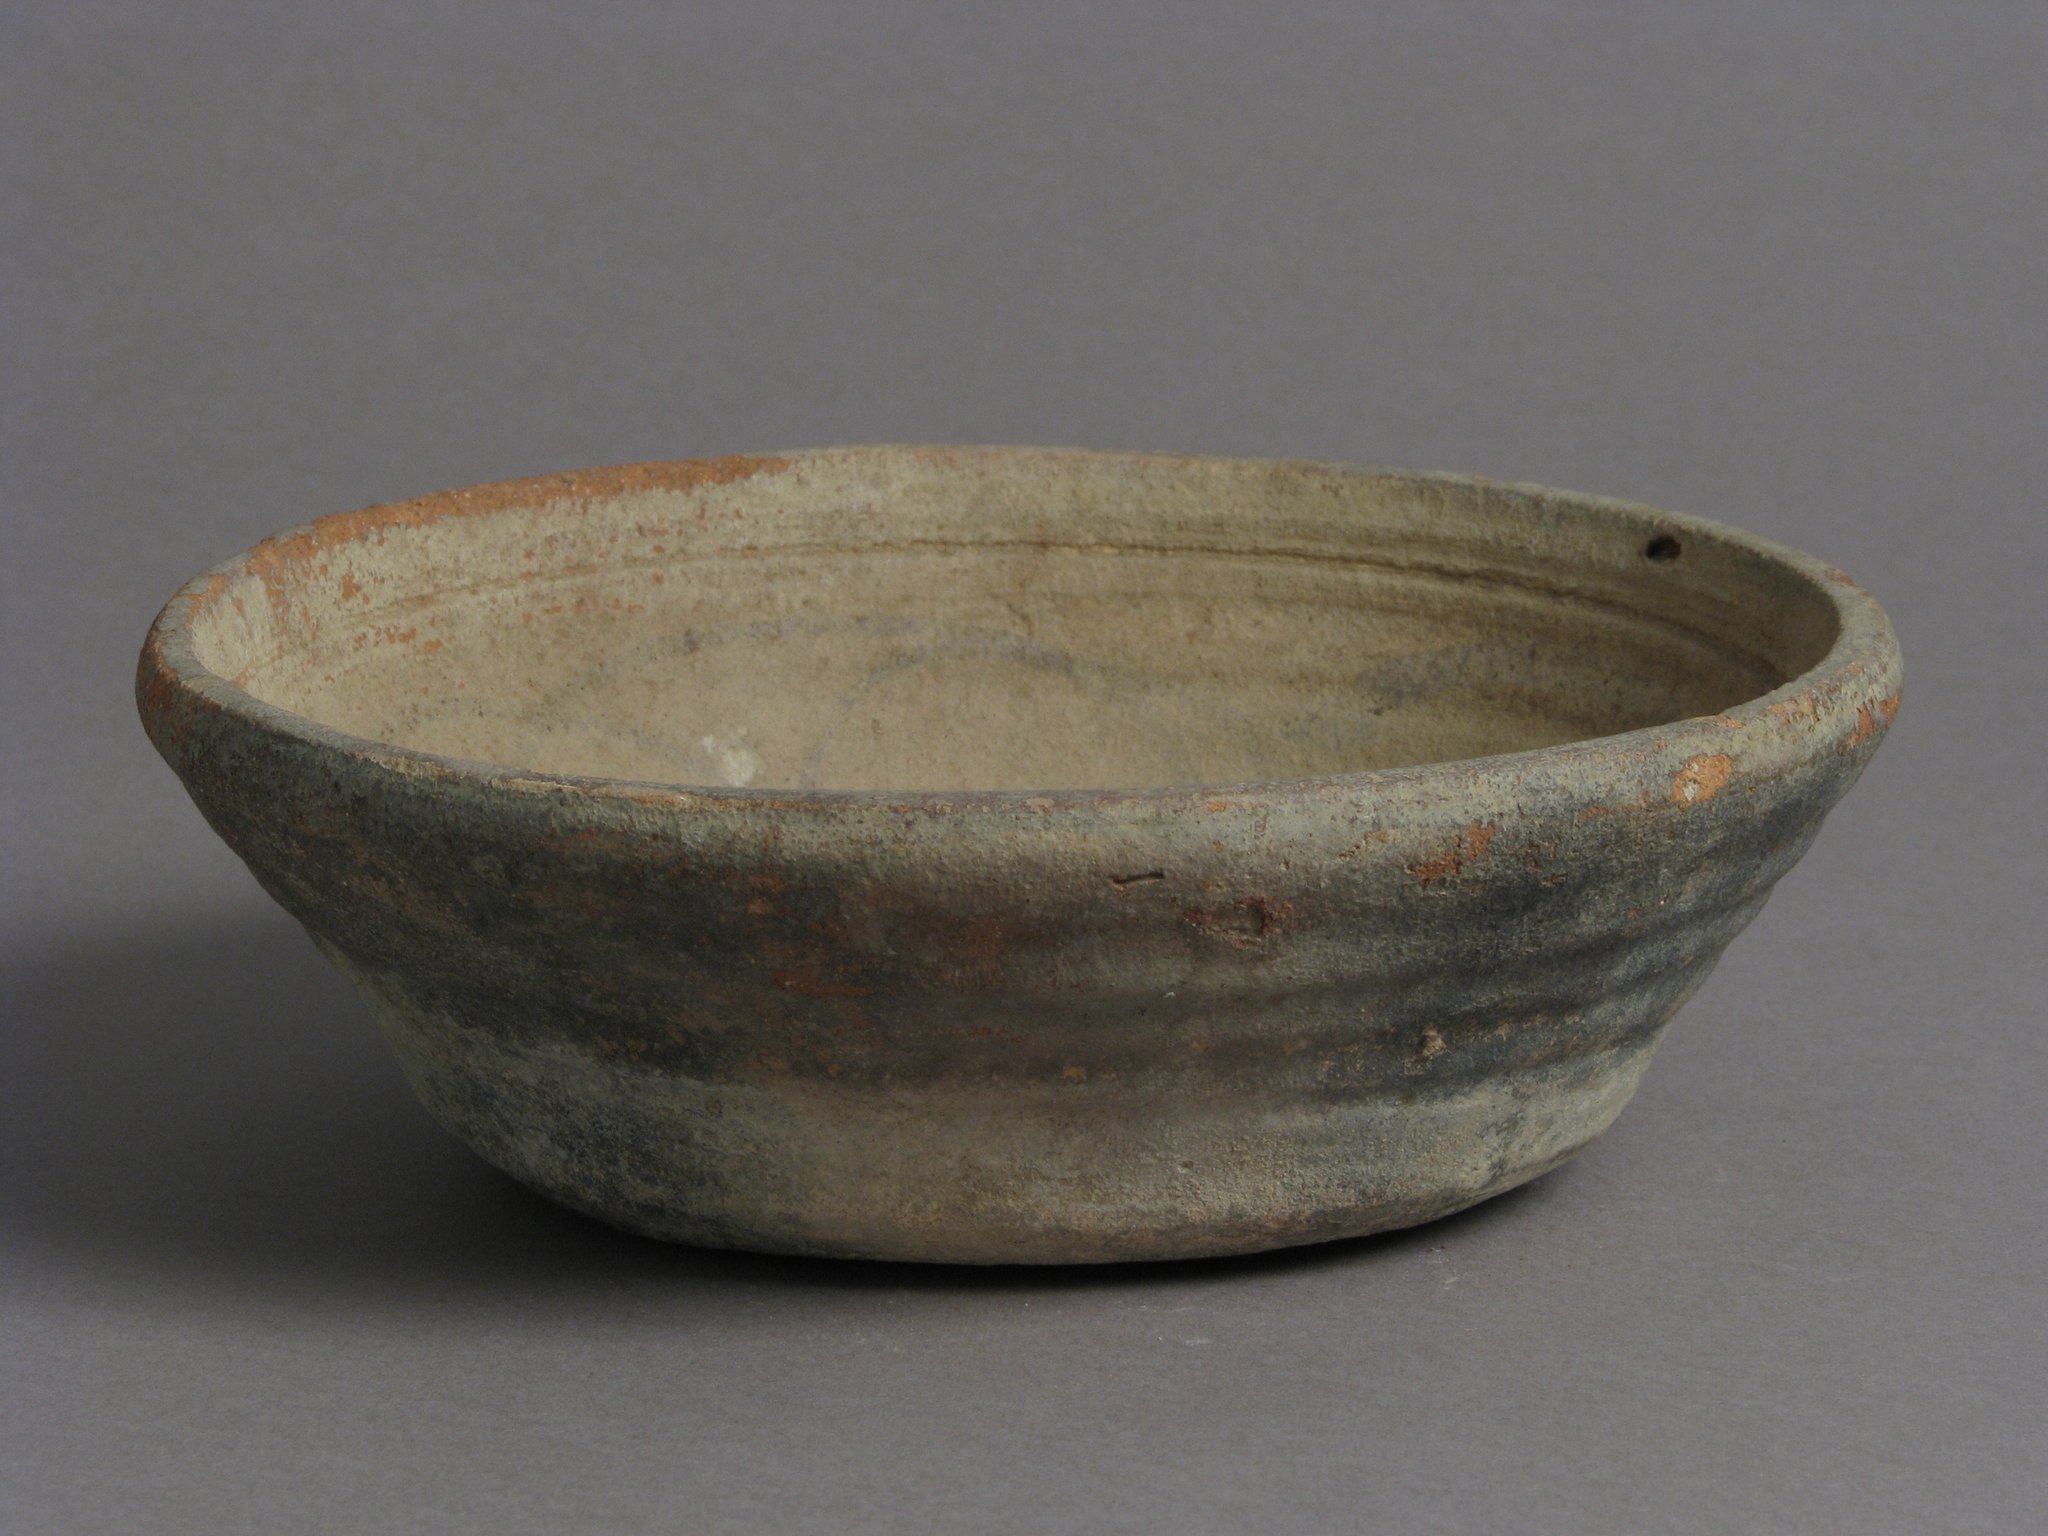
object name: bowl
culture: coptic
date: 301-700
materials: earthenware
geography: egypt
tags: bowls